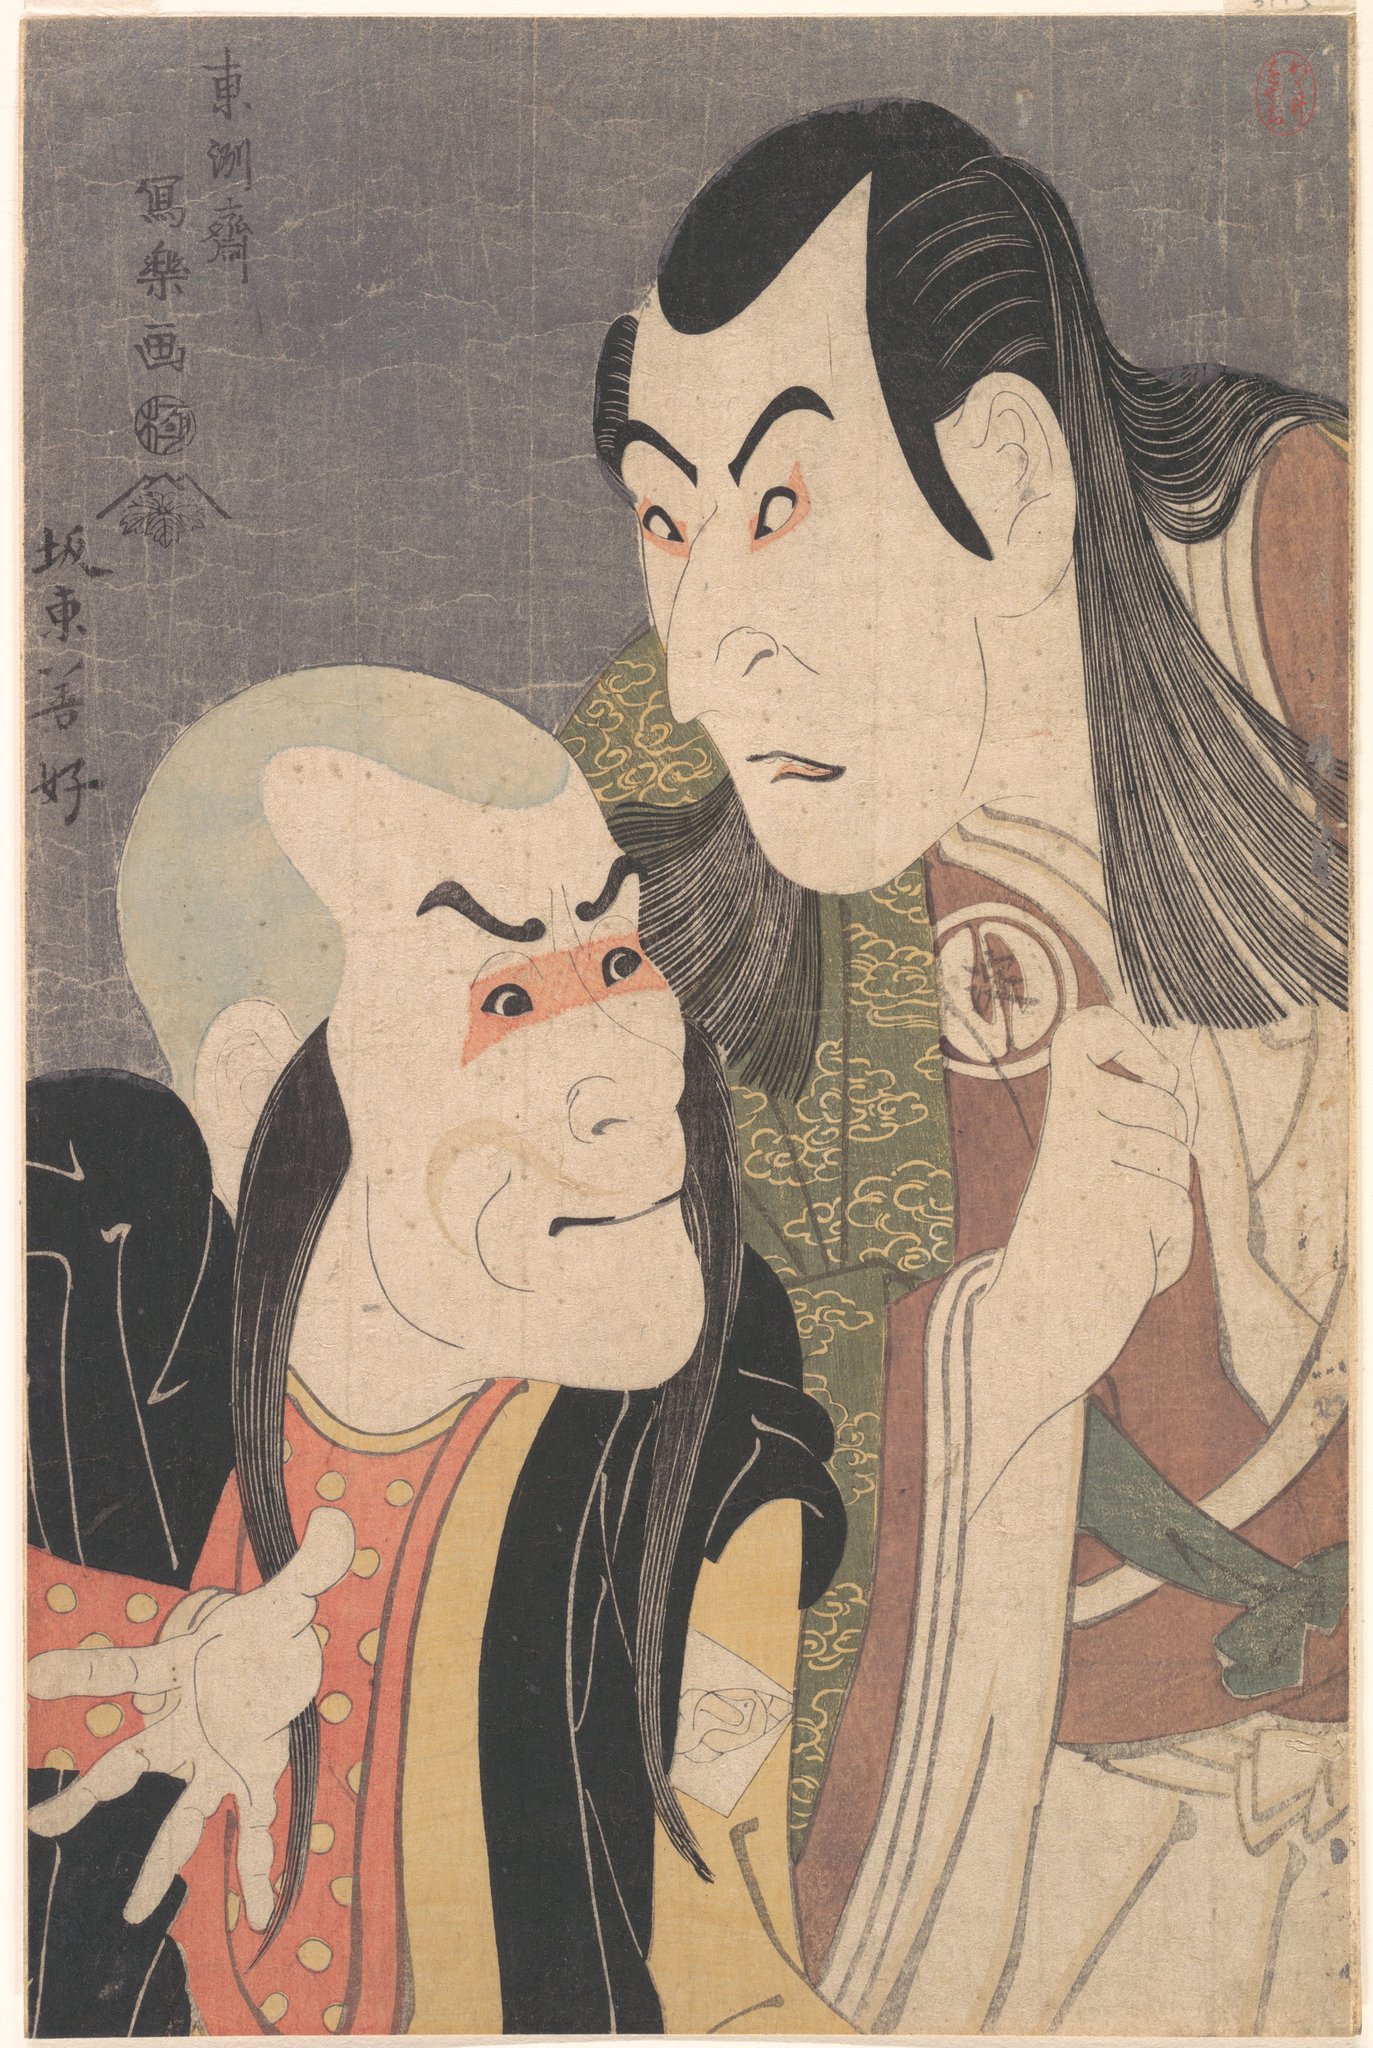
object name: woodblock print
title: Sawamura Yodogorō II and Bandō Zenji as Kawatsura Hōgen and Onisadobō in the Play "Koinyōbō Somewake Tazuna"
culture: japanese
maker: tōshūsai sharaku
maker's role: artist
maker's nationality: japanese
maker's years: 1794-1795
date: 1794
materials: ink, mica, paper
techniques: woodblock print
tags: men,actors